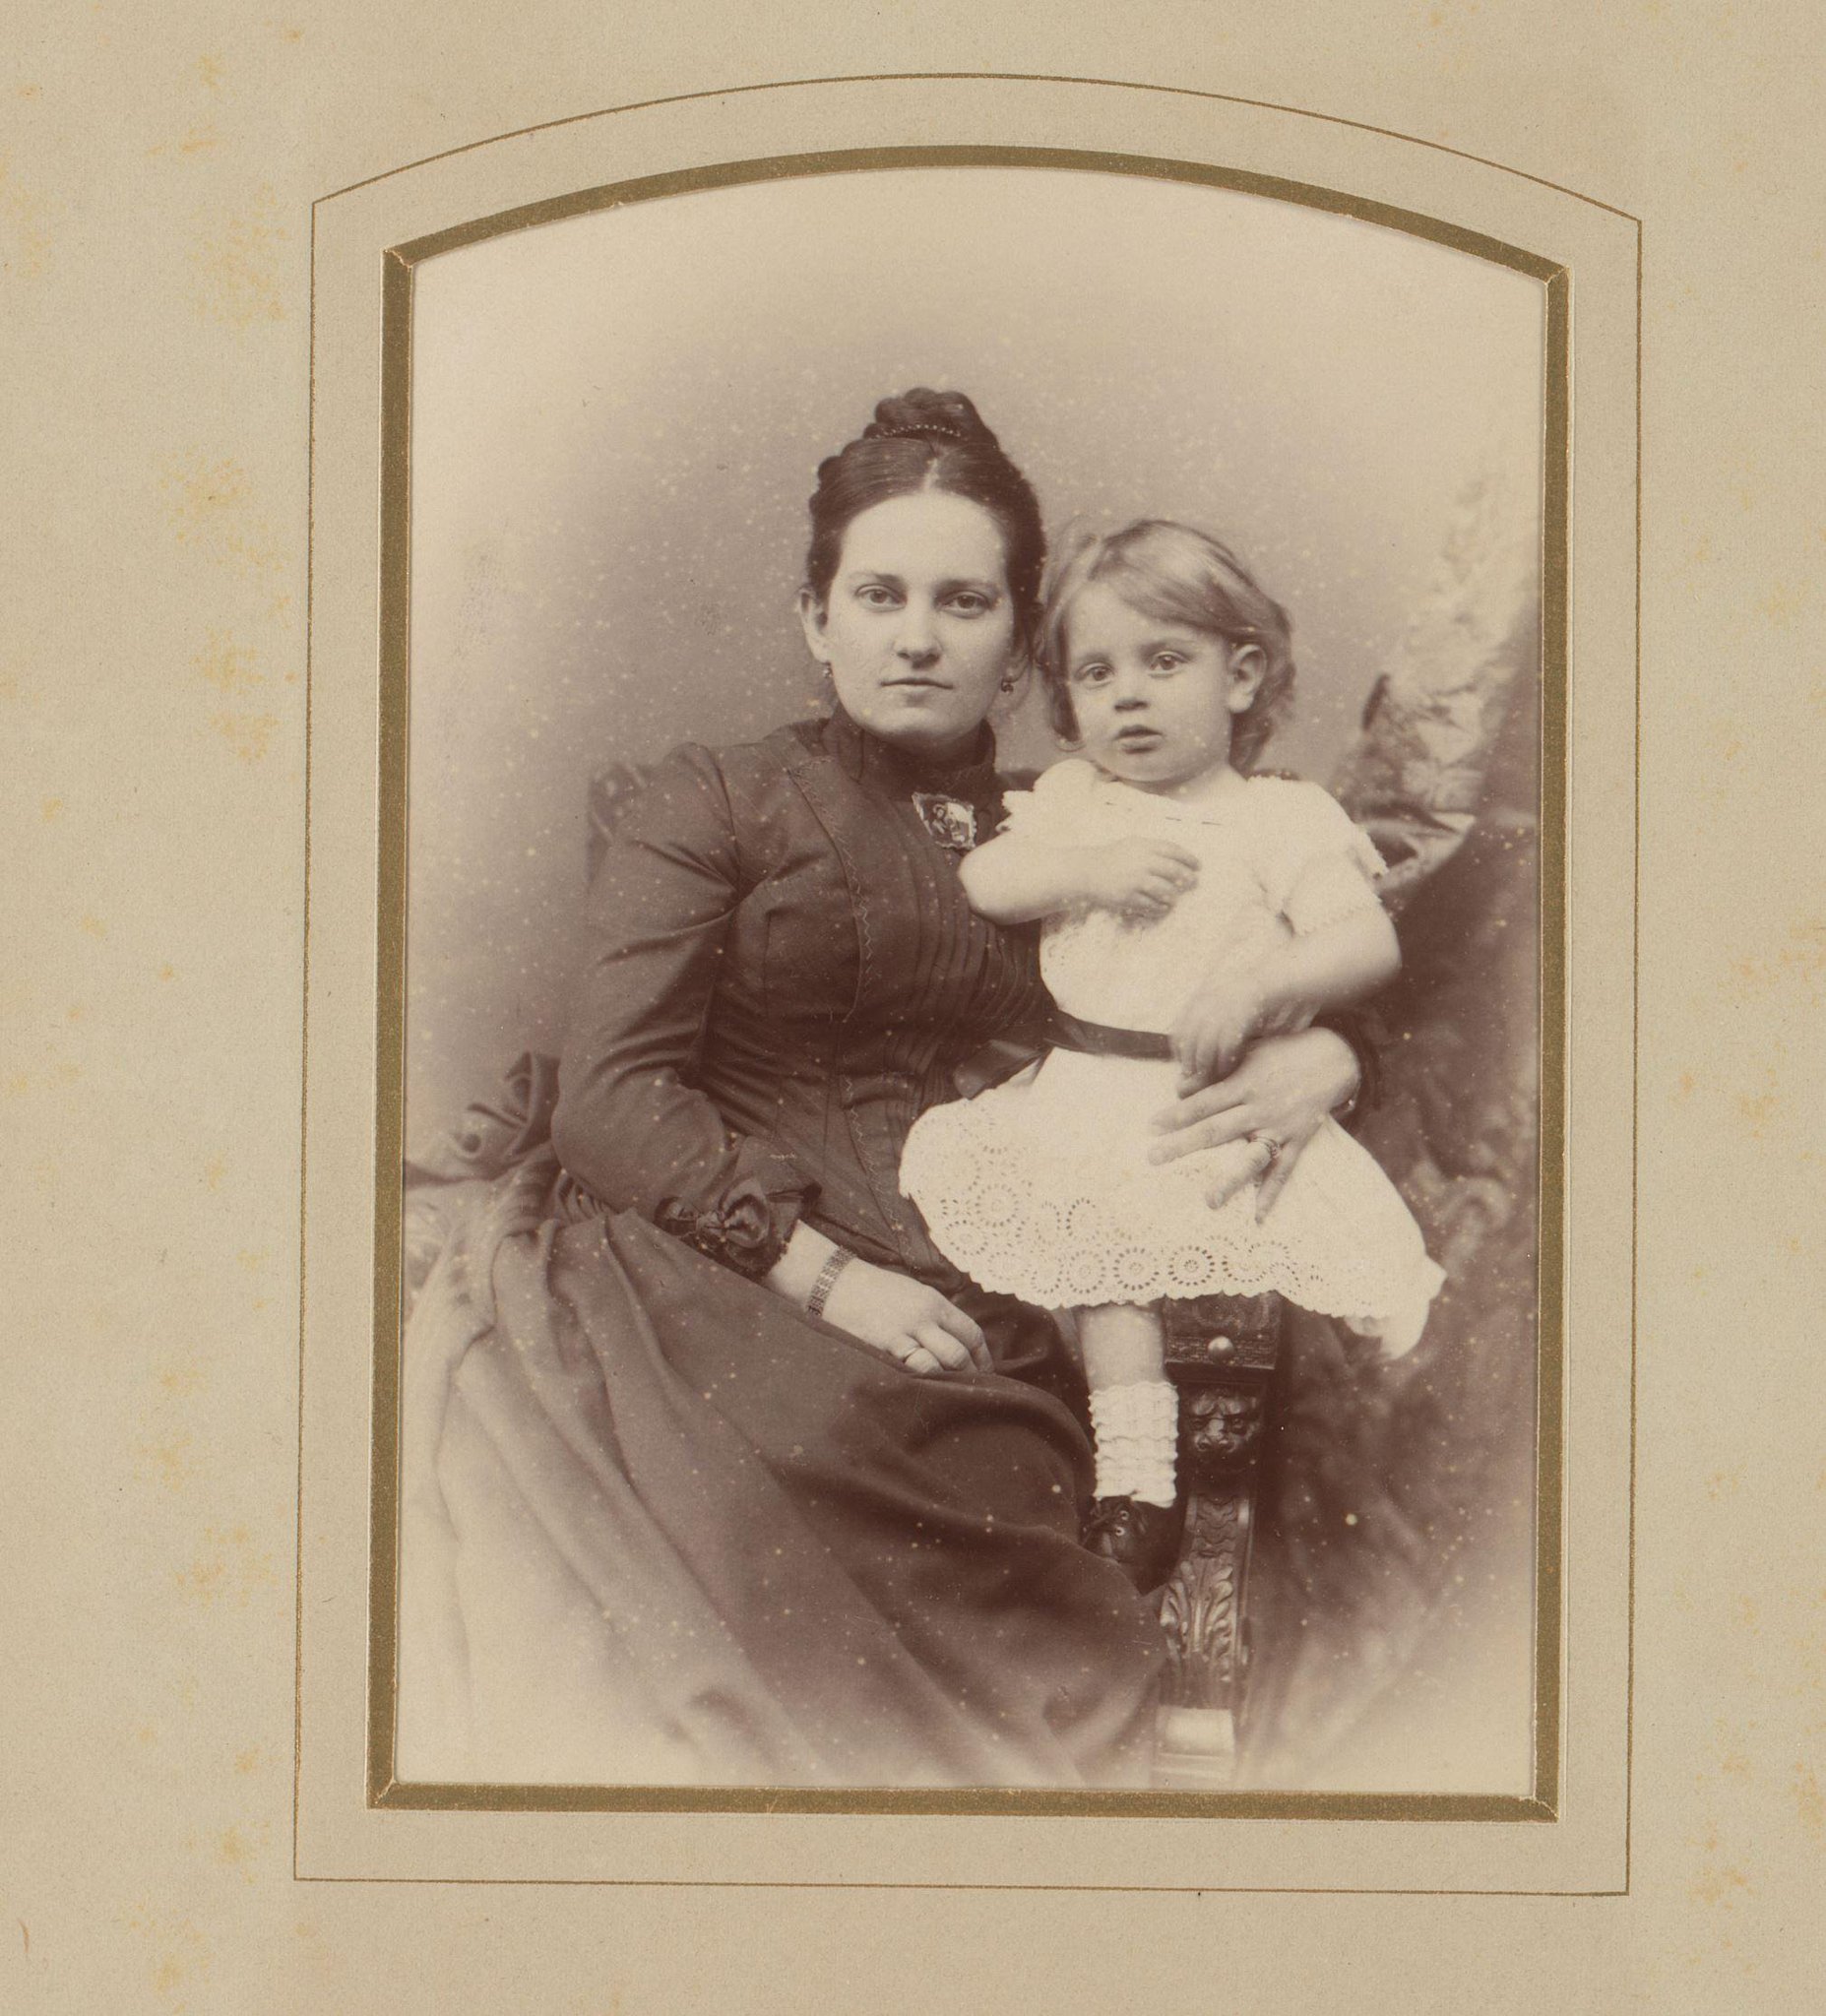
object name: photograph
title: Studioportret van moeder en dochter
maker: kameke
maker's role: painter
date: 1890-1920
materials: paper, photographic support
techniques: photography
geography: the hague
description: Studioportret van van moeder en dochter. De moeder draagt een zwarte hooggesloten jurk met een kraag afgesloten met een broche. De dochter draagt een witte jurk, samen zitten zij op een stoel.